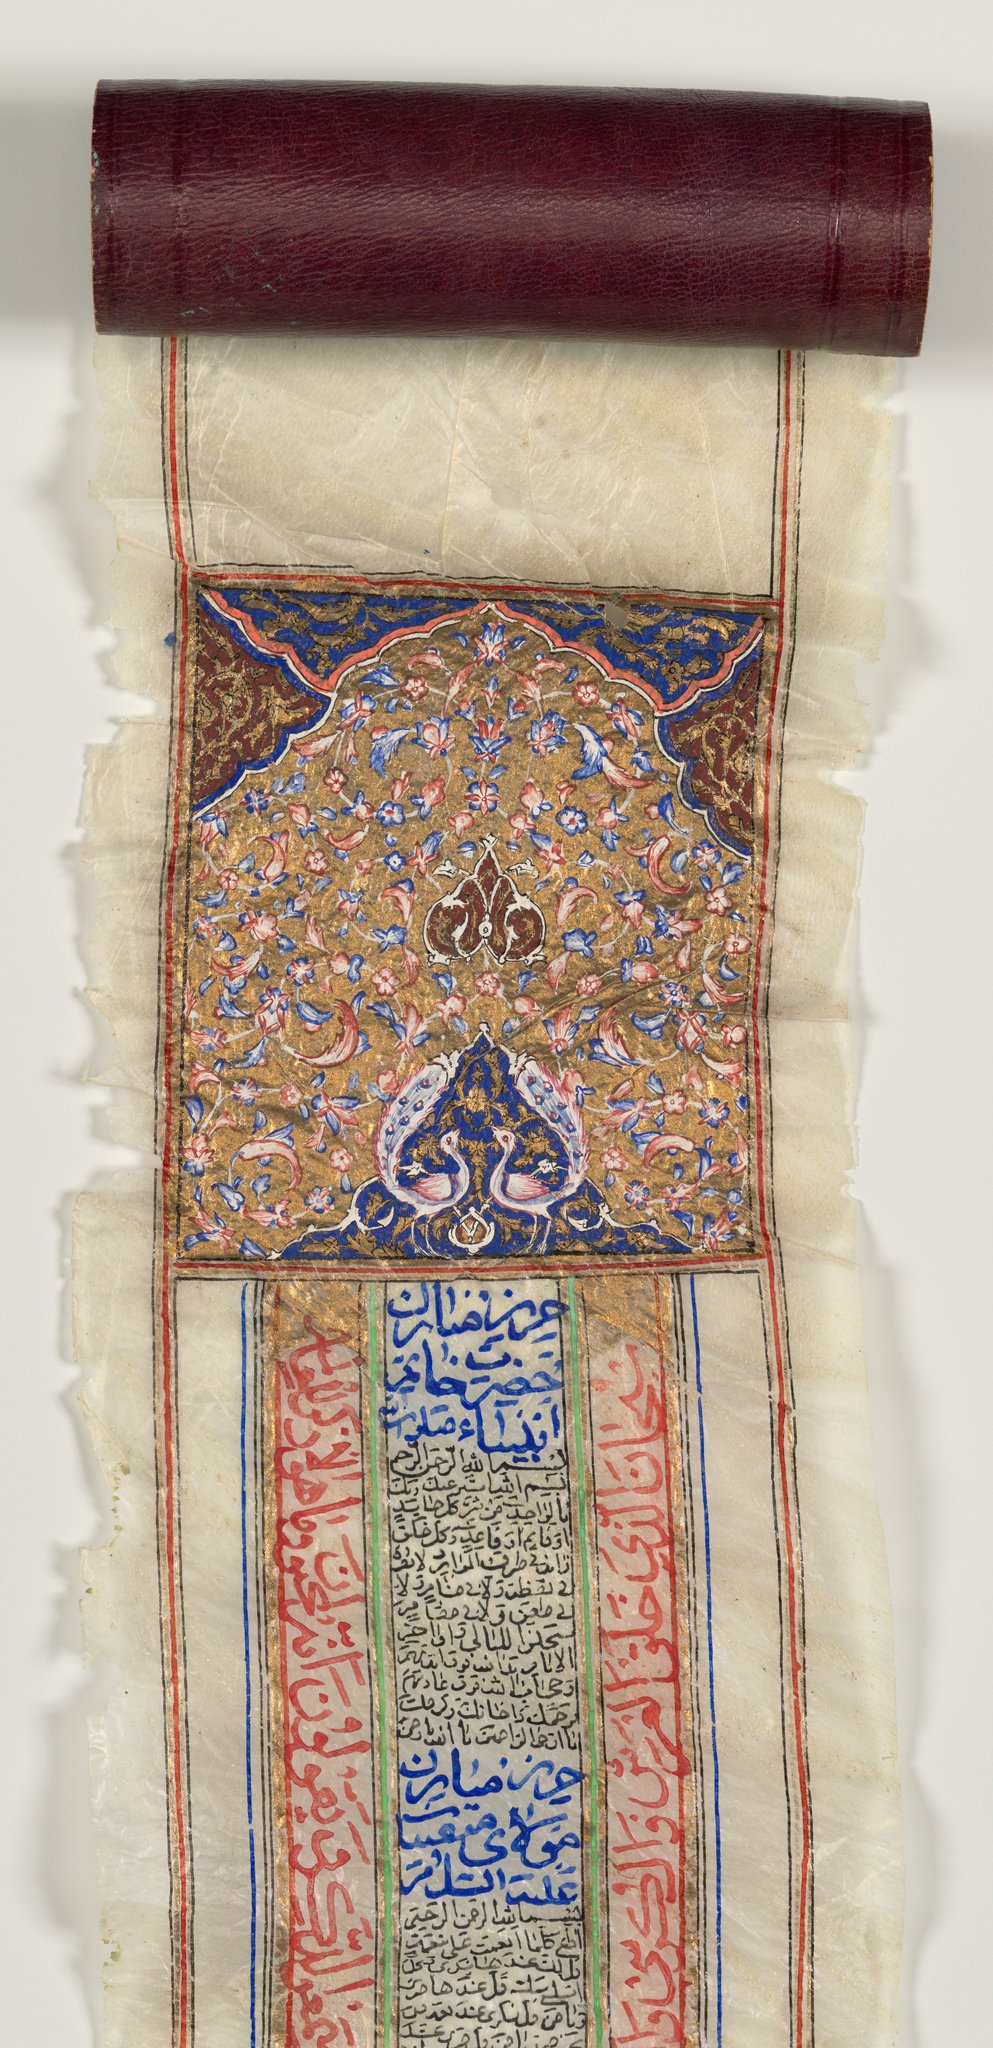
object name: scroll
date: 1601-1900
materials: gold, ink, leather, skin, watercolor